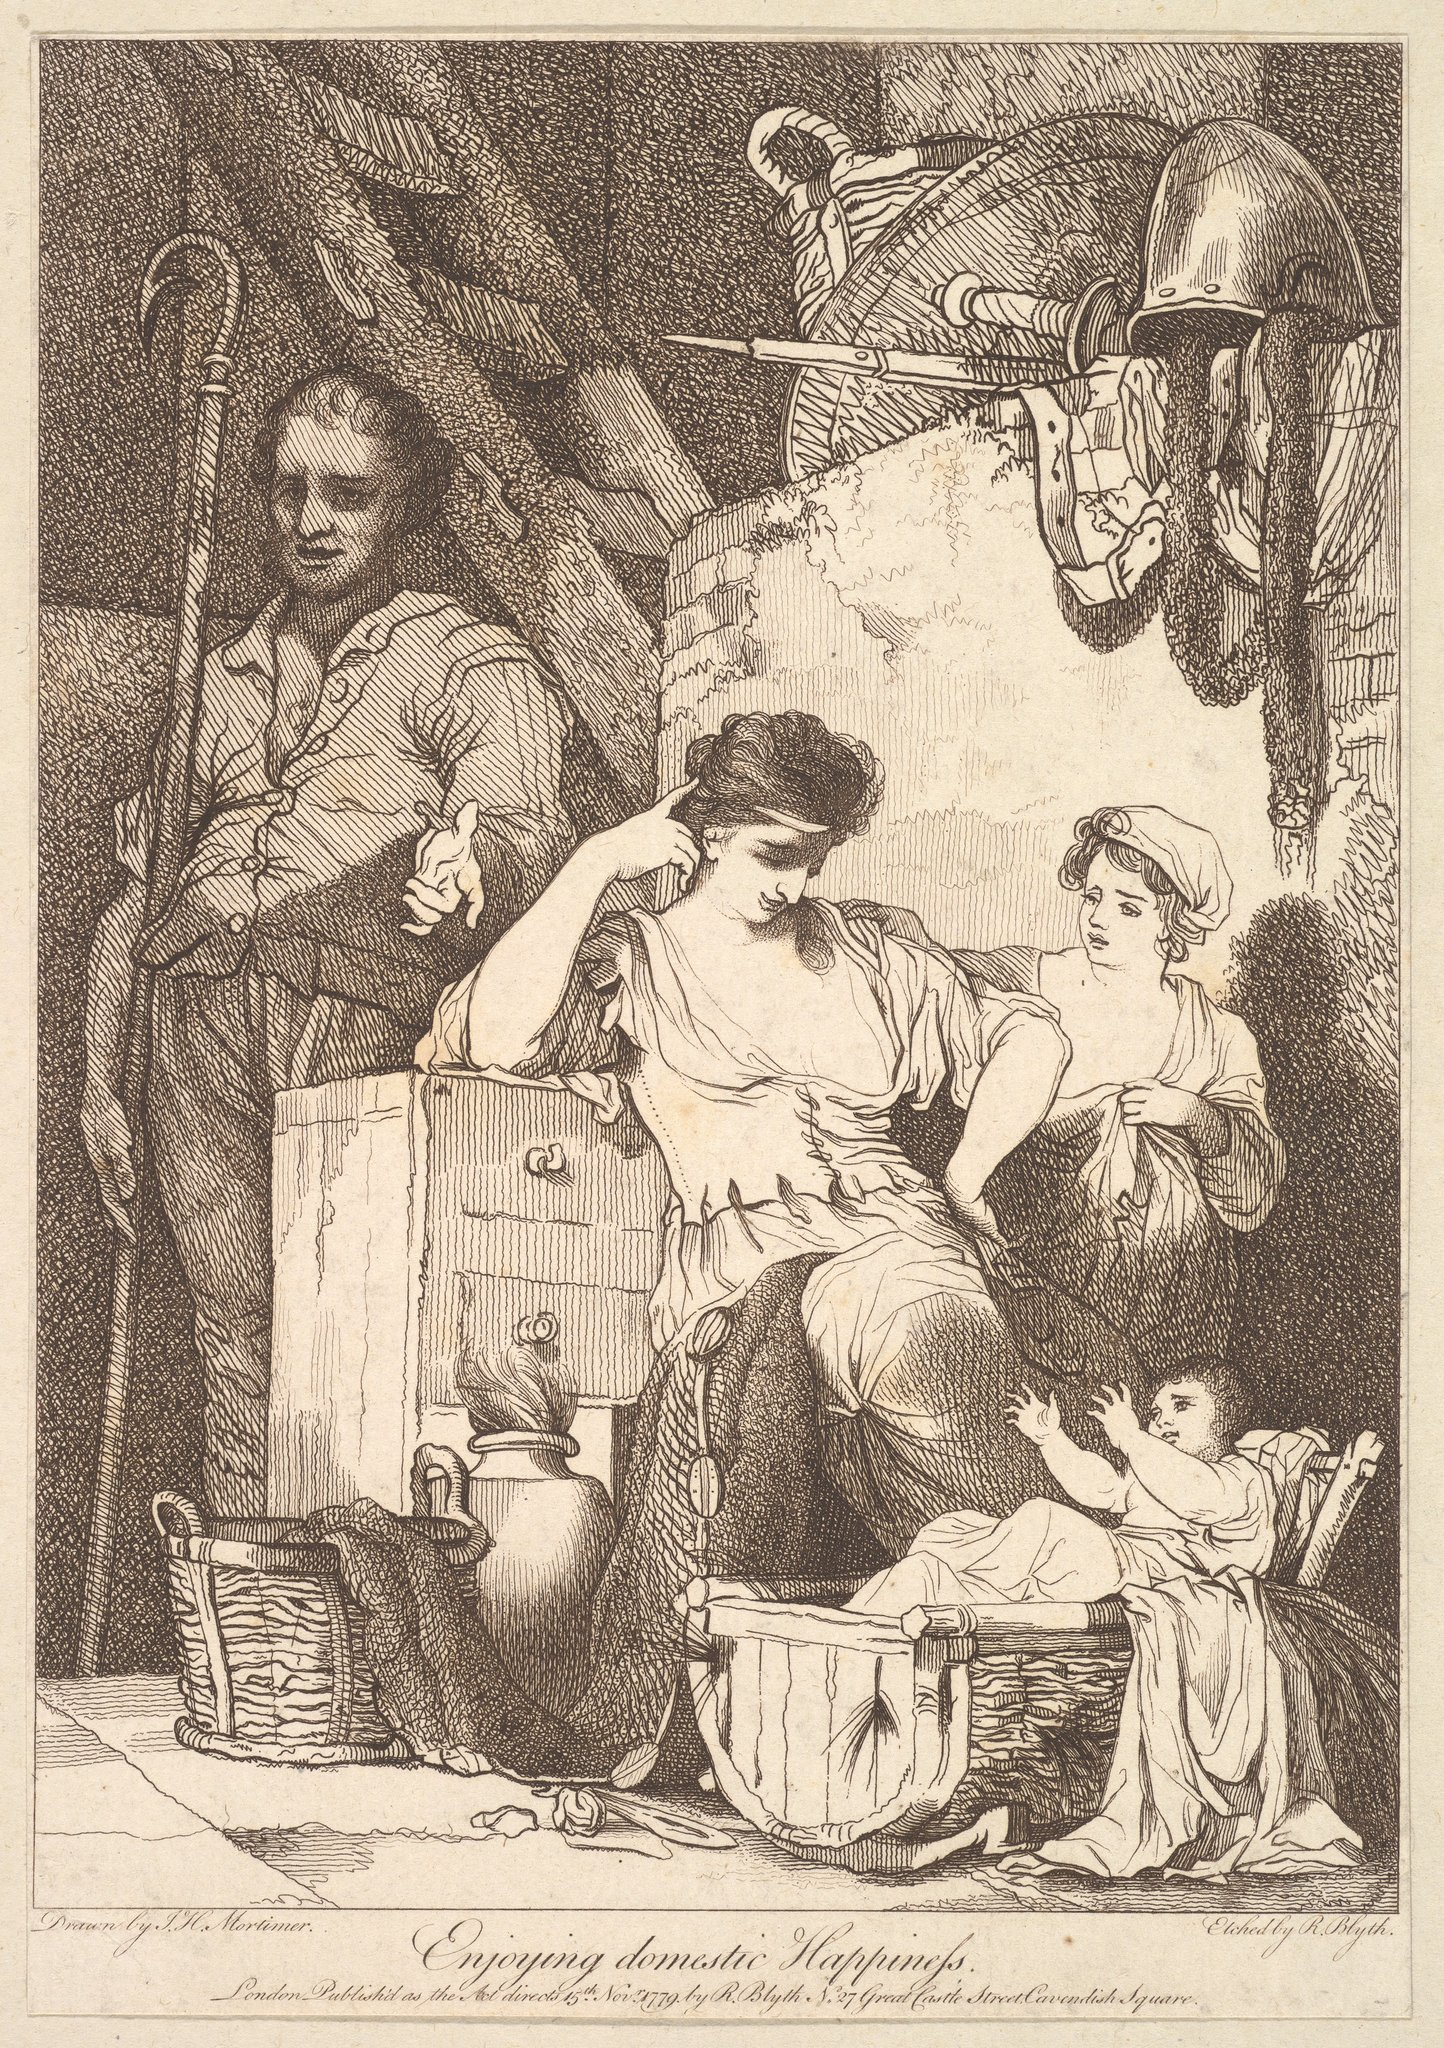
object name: print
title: Enjoying Domestic Happiness, from "Banditti Variously Employed"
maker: robert blyth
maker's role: artist and publisher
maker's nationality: british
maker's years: 1750-1784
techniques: etching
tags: children,men,women